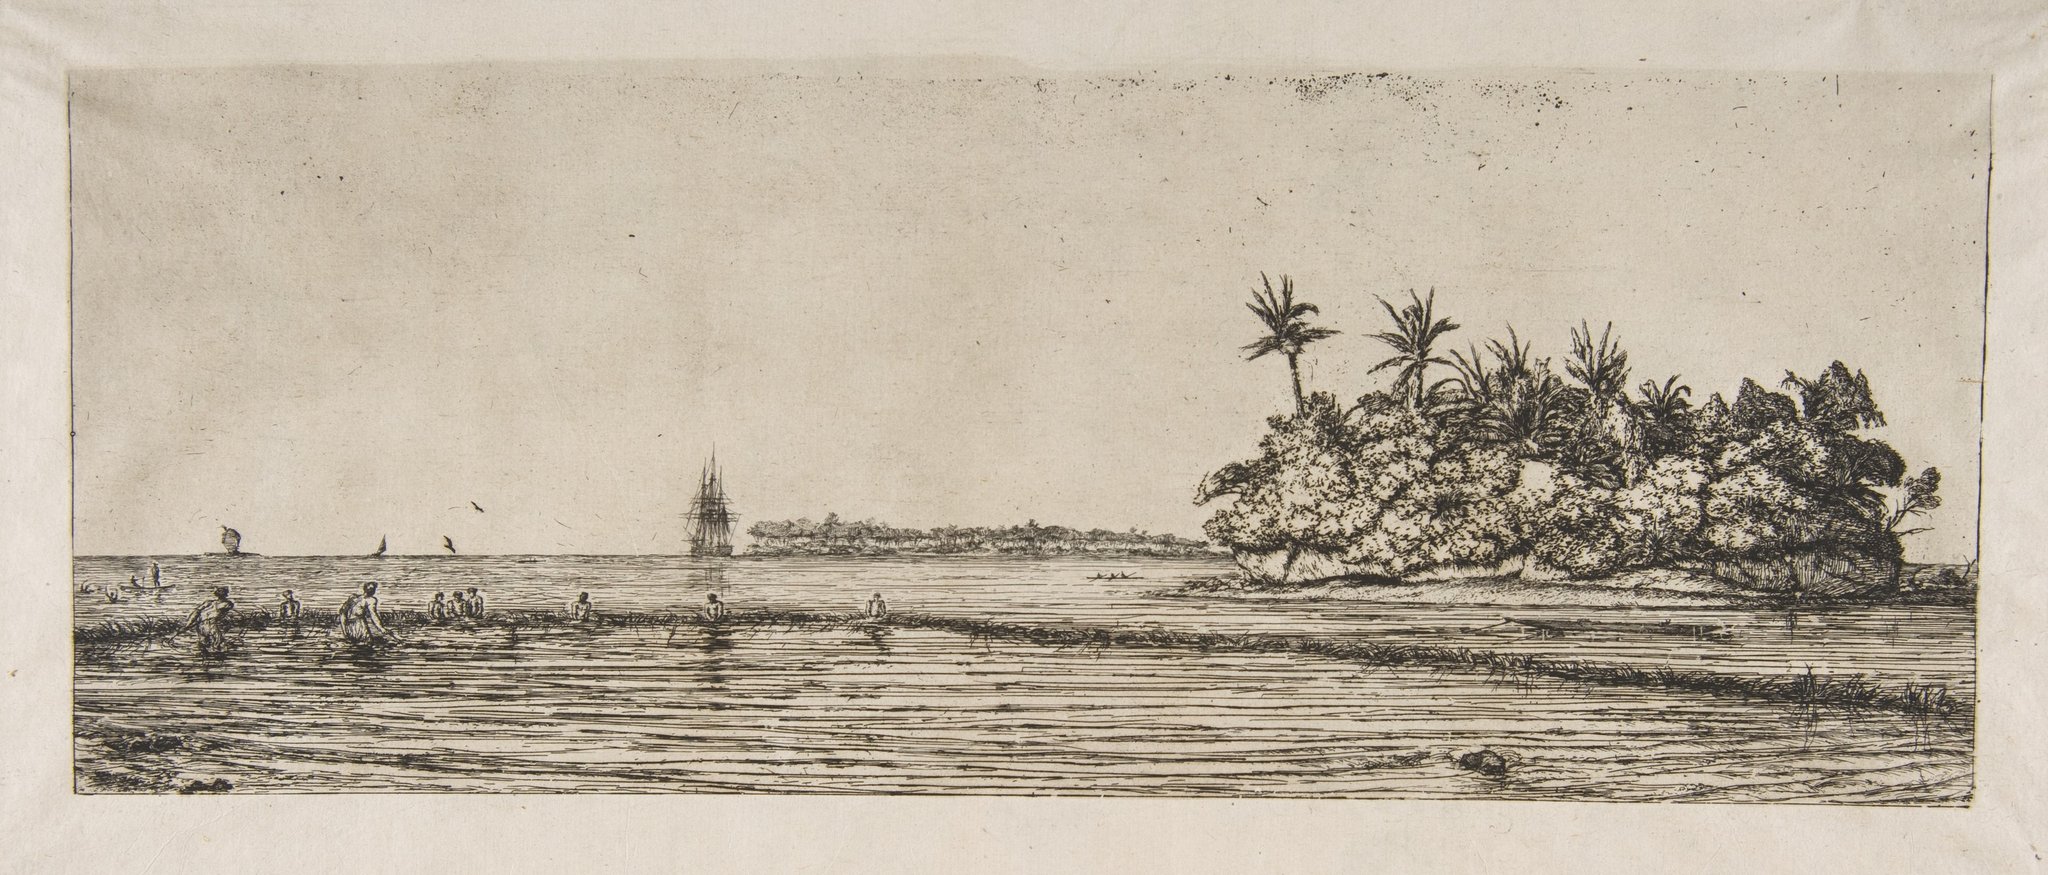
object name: print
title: Océanie: Îlots à Uvea (Wallis): Pêche aux Palmes, 1845 (Oceania: Fishing, near islands with palms in the Uea or Wallis Group, 1845), from "The Voyage to New Zealand (1842–46)"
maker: charles meryon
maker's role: artist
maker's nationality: french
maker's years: 1821-1868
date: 1863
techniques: drypoint, etching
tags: fishing,ships